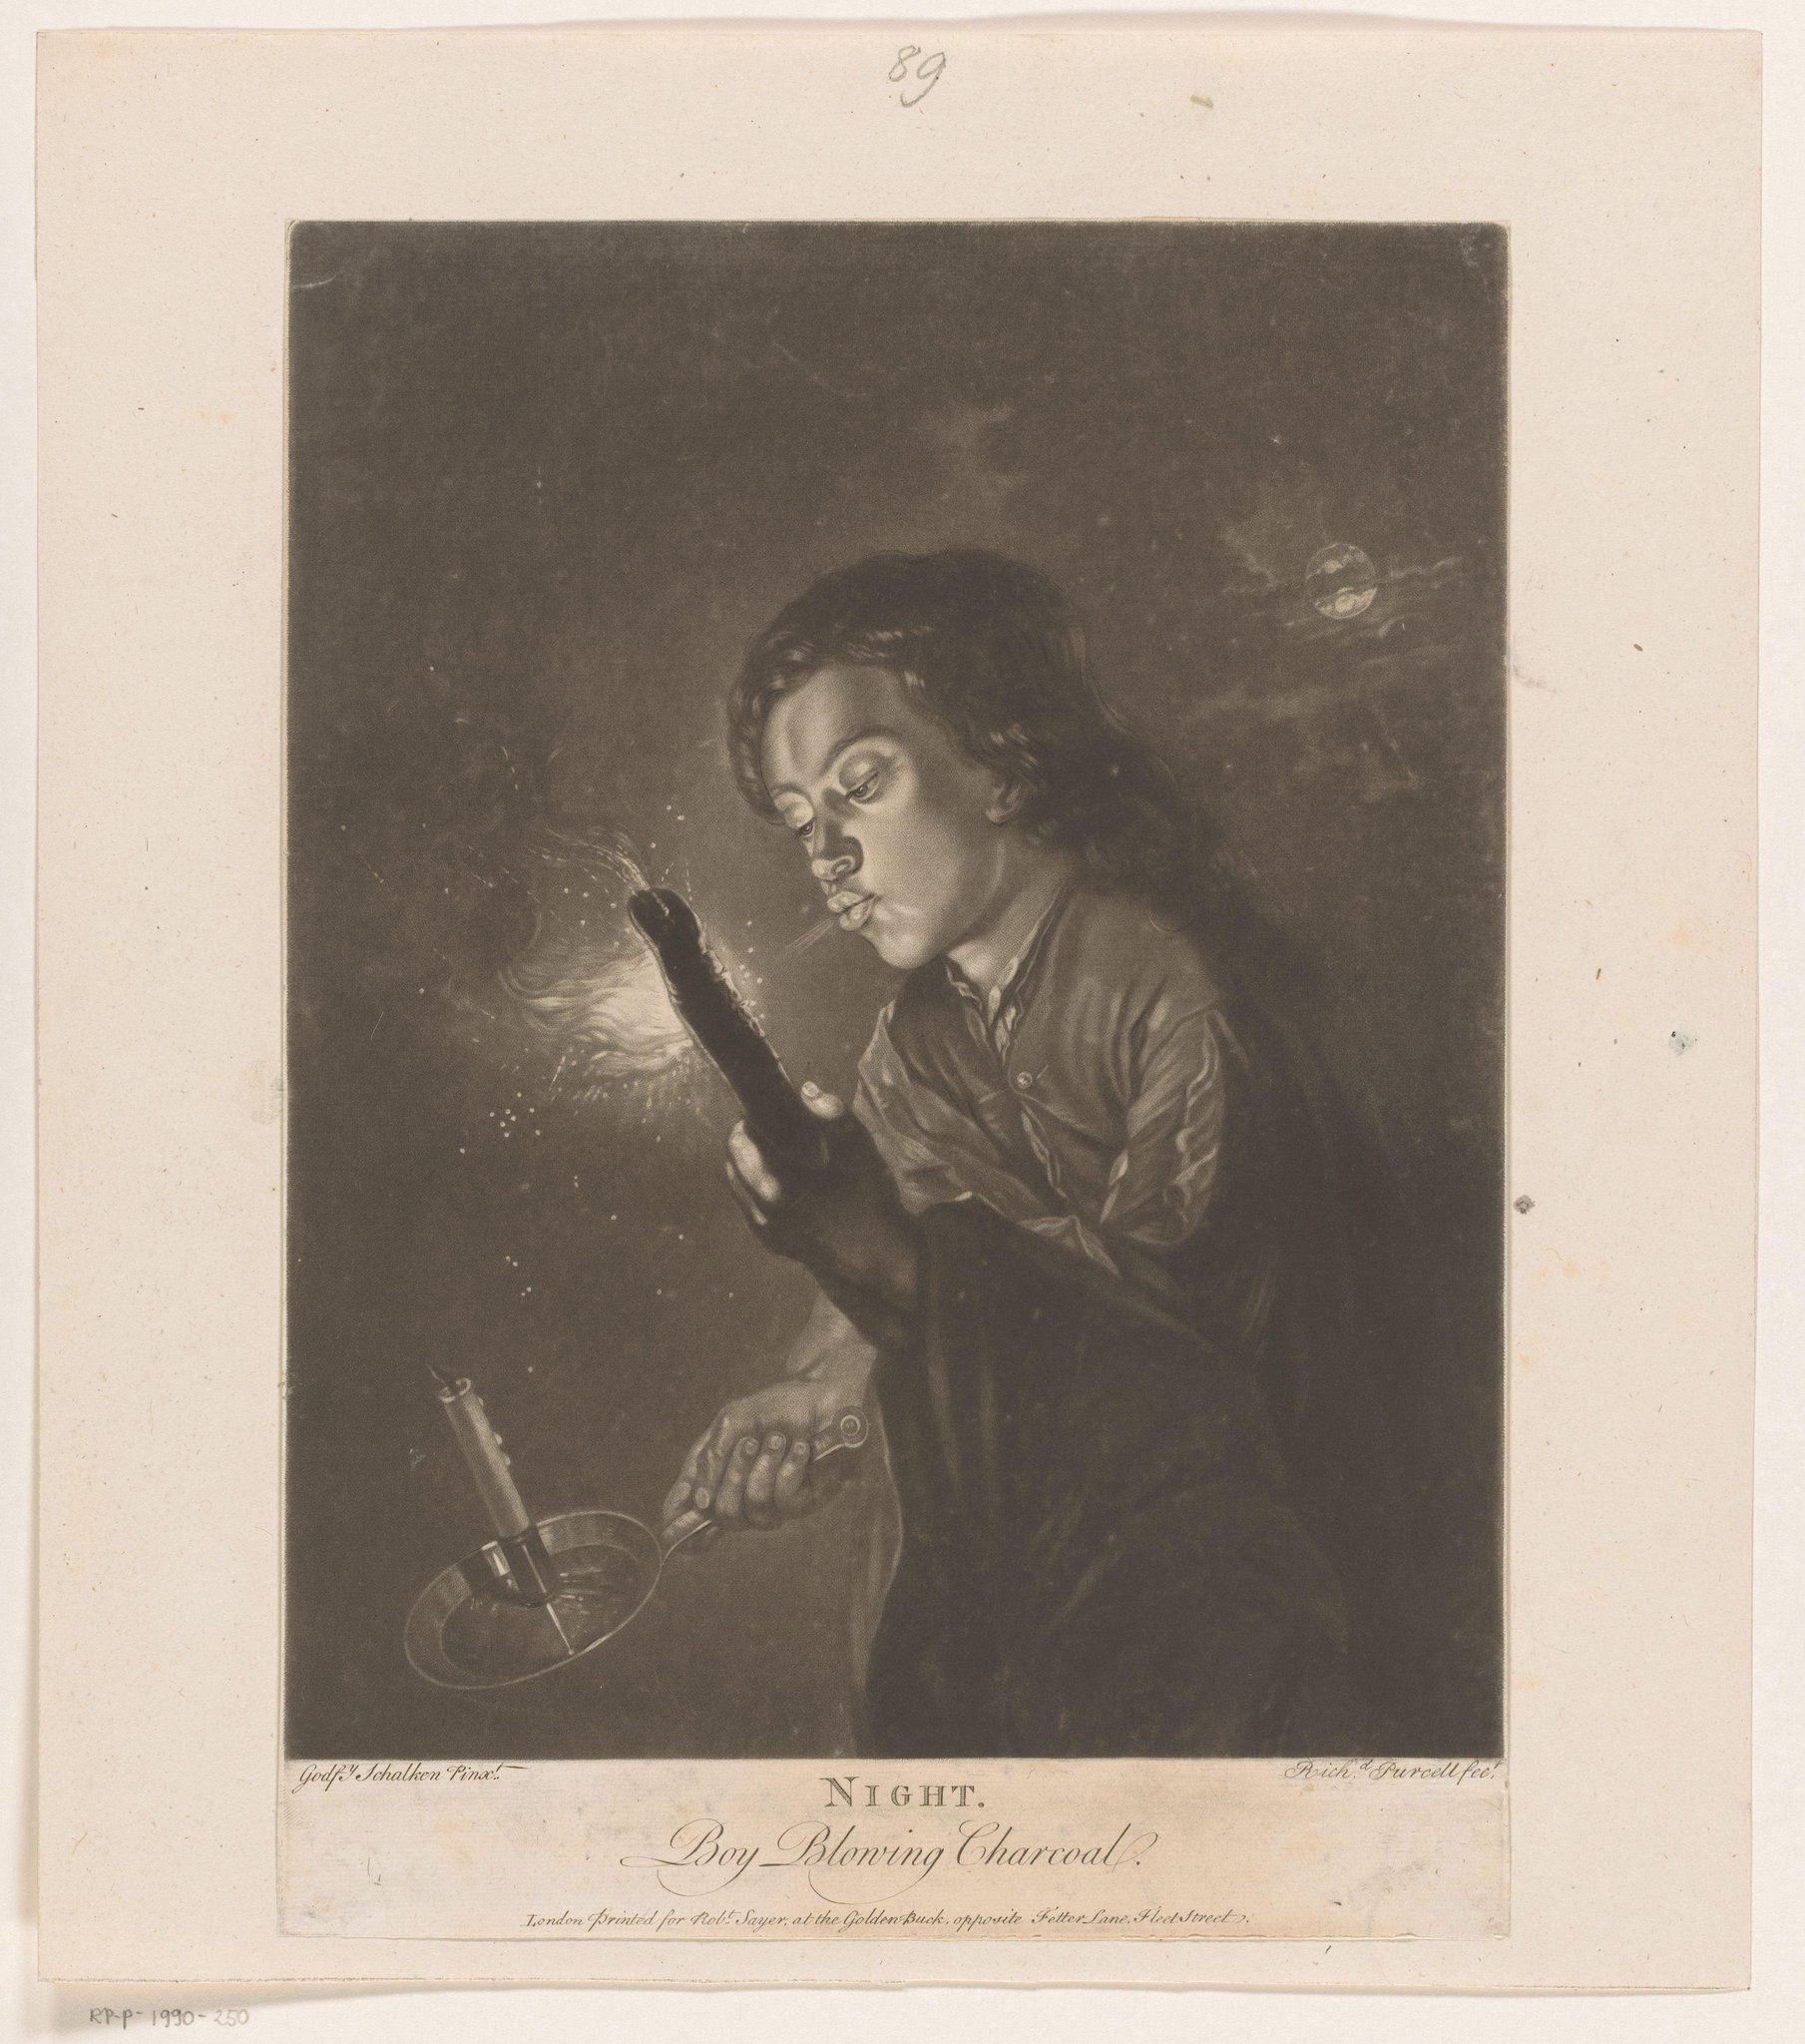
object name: print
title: Jongen blaast tegen een fakkel van houtskool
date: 1746-1794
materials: paper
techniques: etching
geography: london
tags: blowing (stirring up a fire), cheeks rounded, youth, adolescent, night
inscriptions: collector's mark: Lugt 2228, collector's mark: Lugt 2760